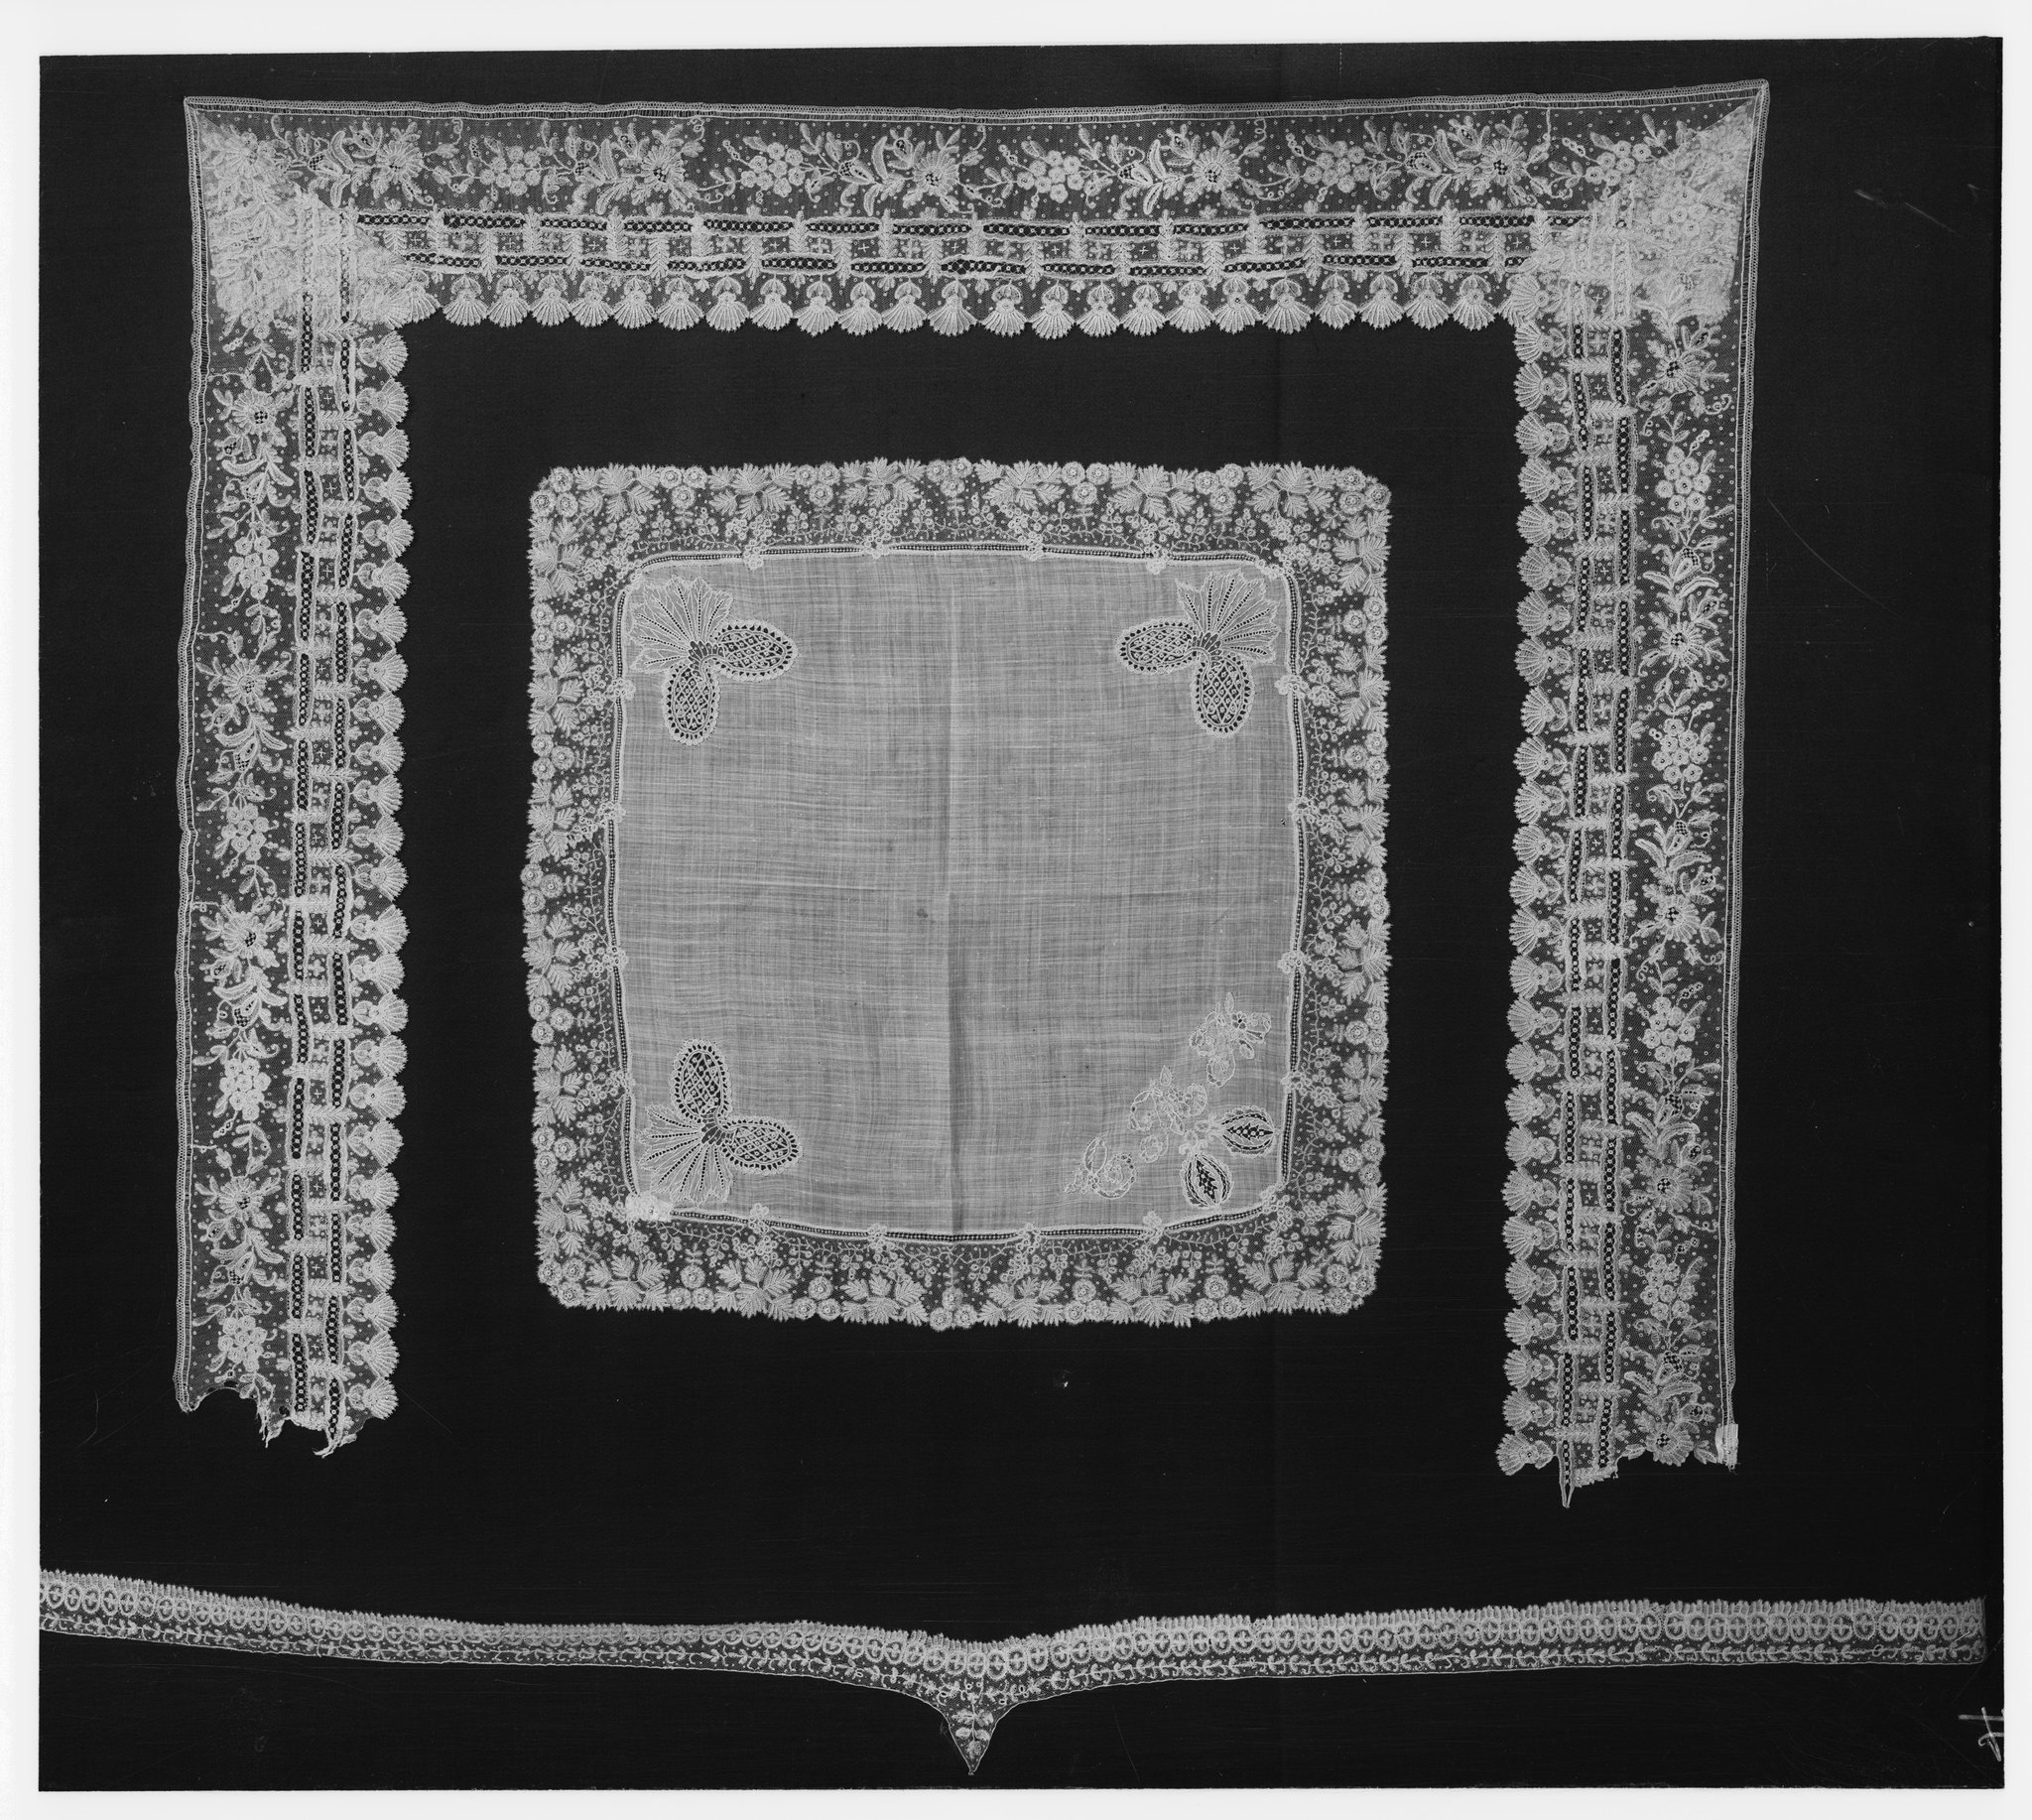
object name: border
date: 1870